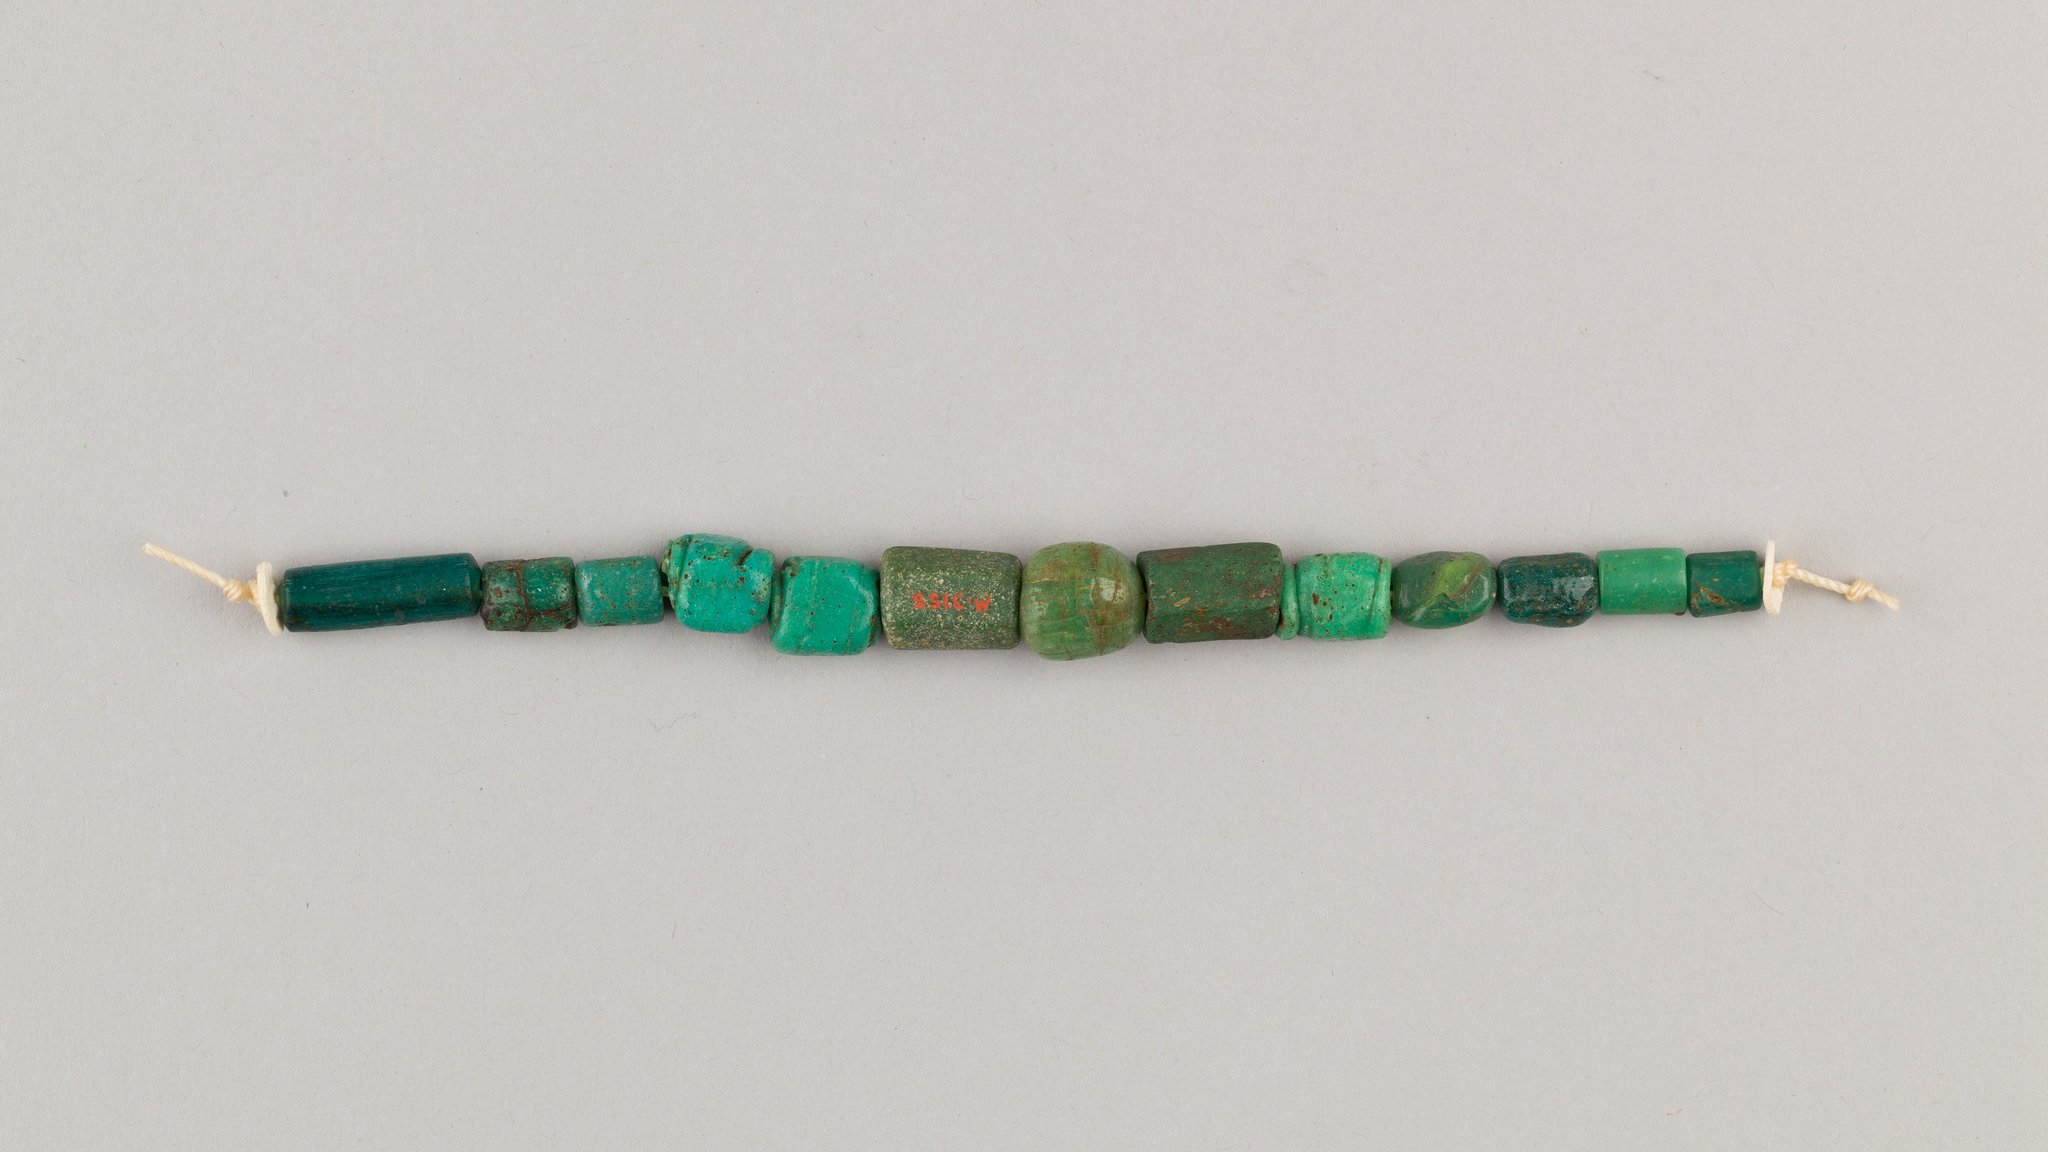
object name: bead, string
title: String of 13 beads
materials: glass, stone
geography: egypt